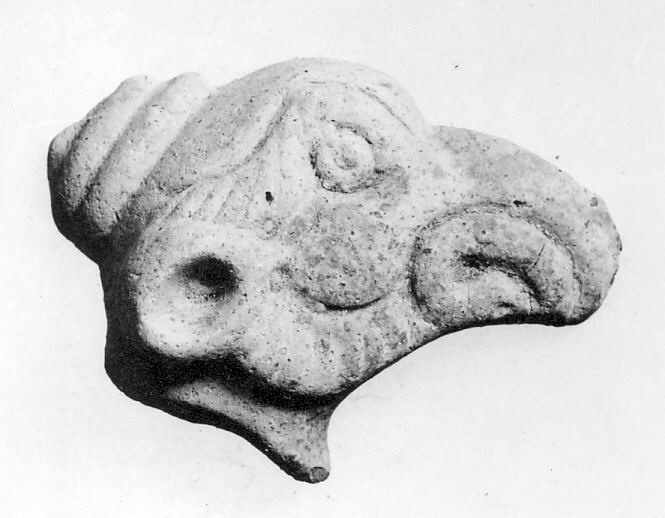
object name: head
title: Grotesque Head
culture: central asian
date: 1101-1133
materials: earthenware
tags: heads